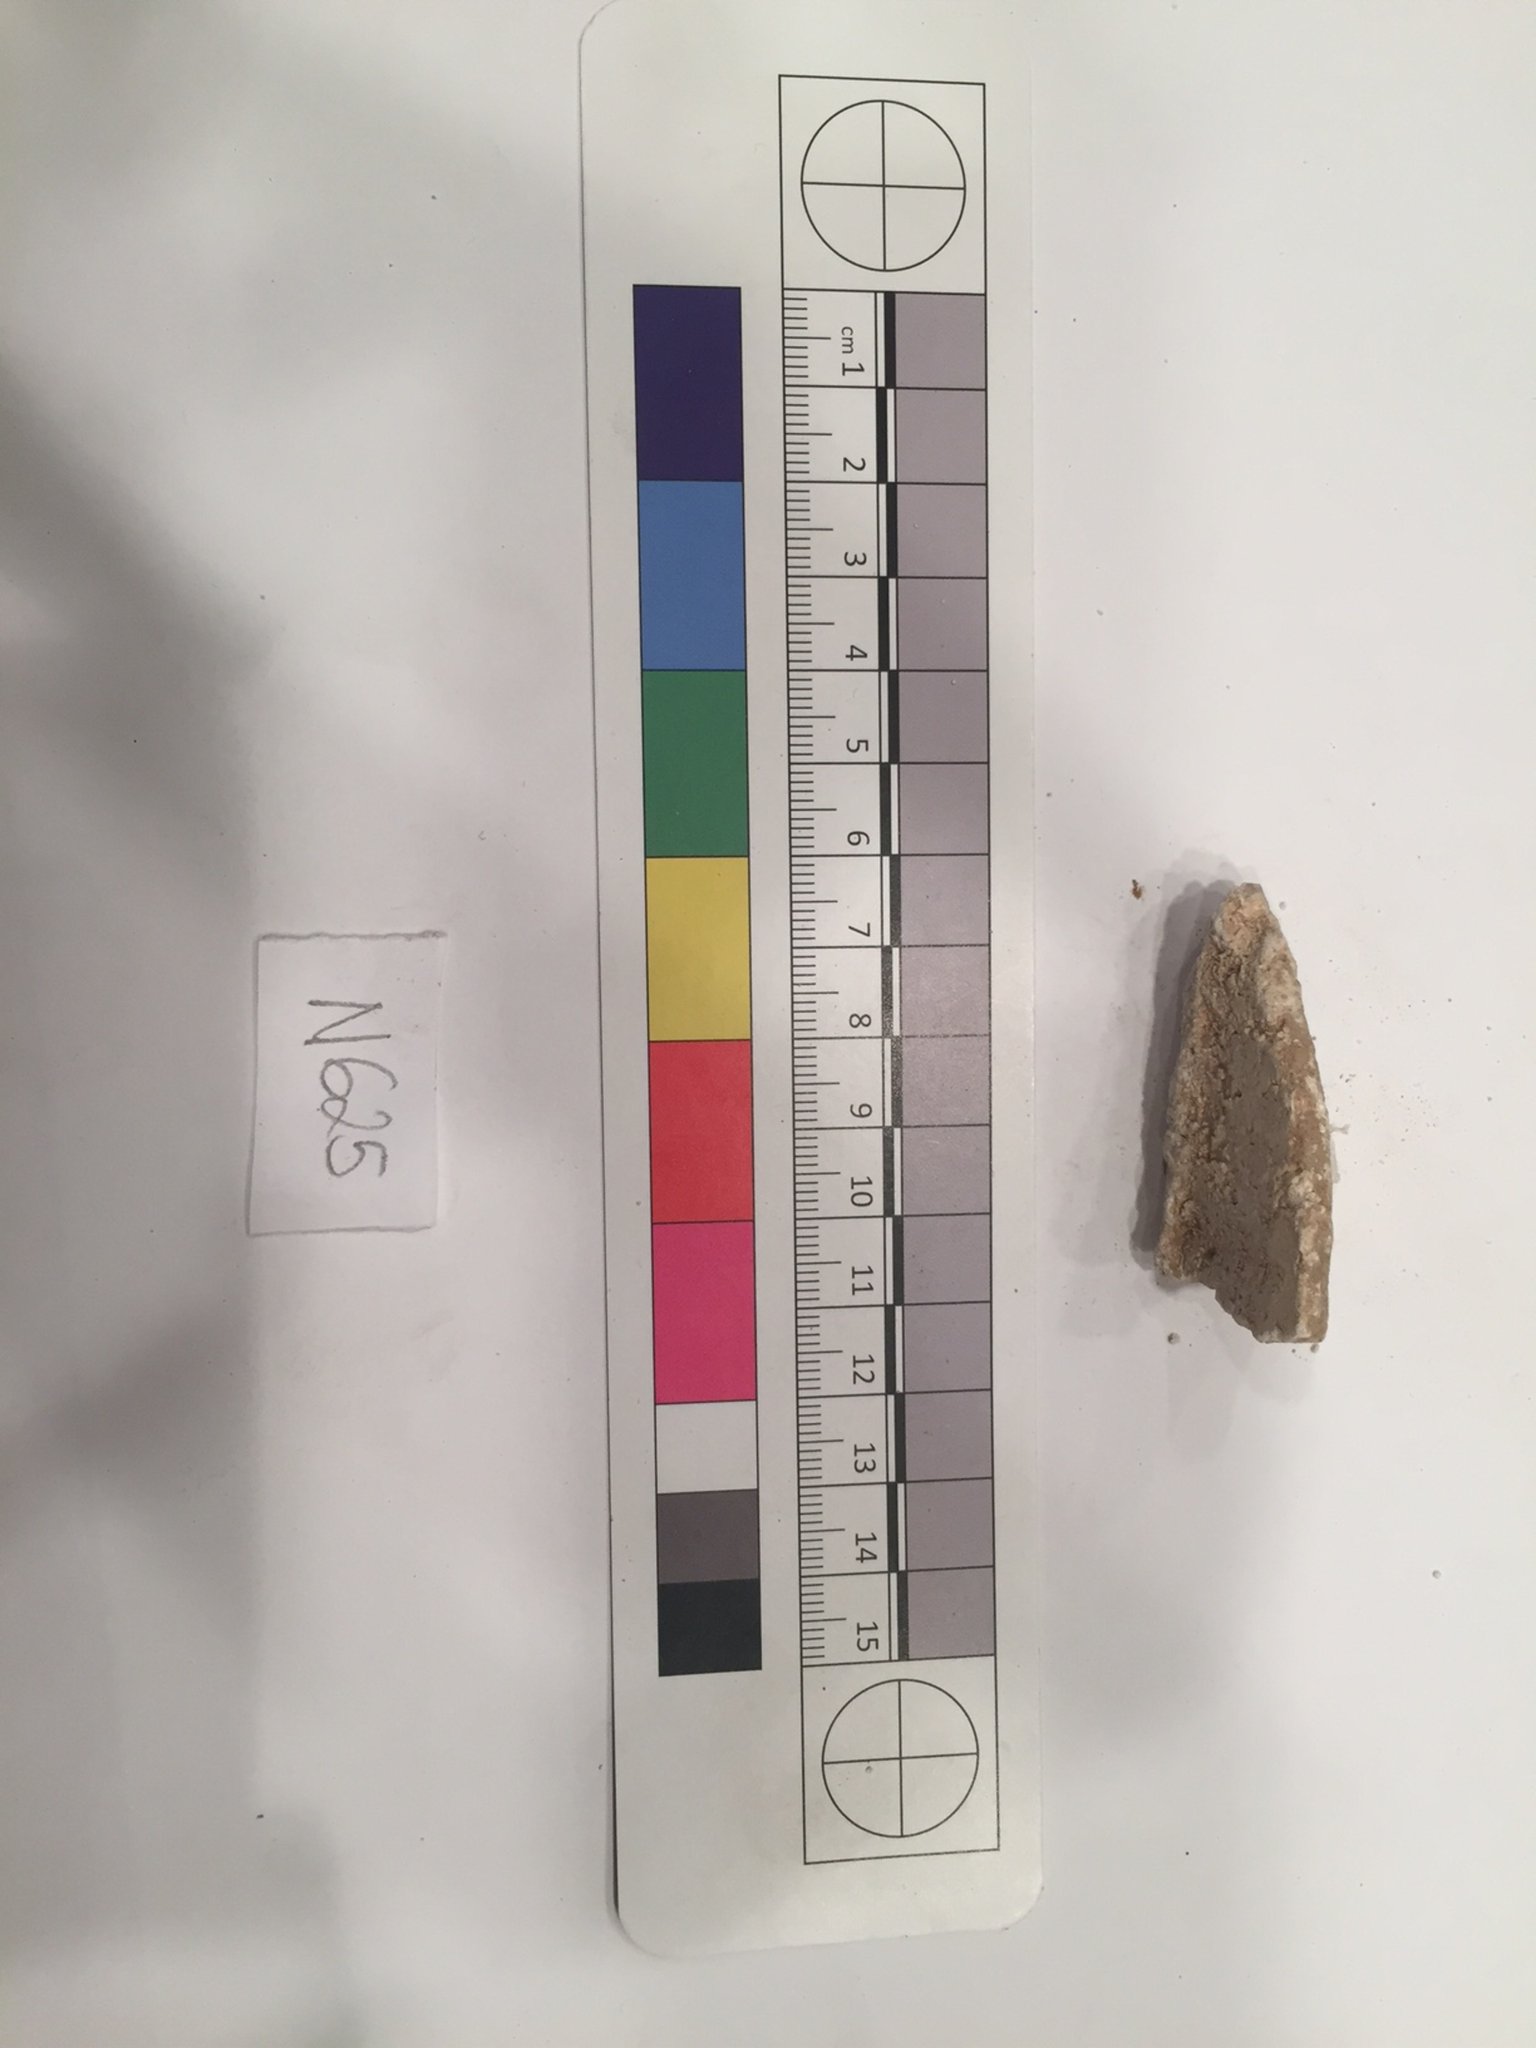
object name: fragment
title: Stucco Fragment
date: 701-1200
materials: plaster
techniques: carving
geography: iran